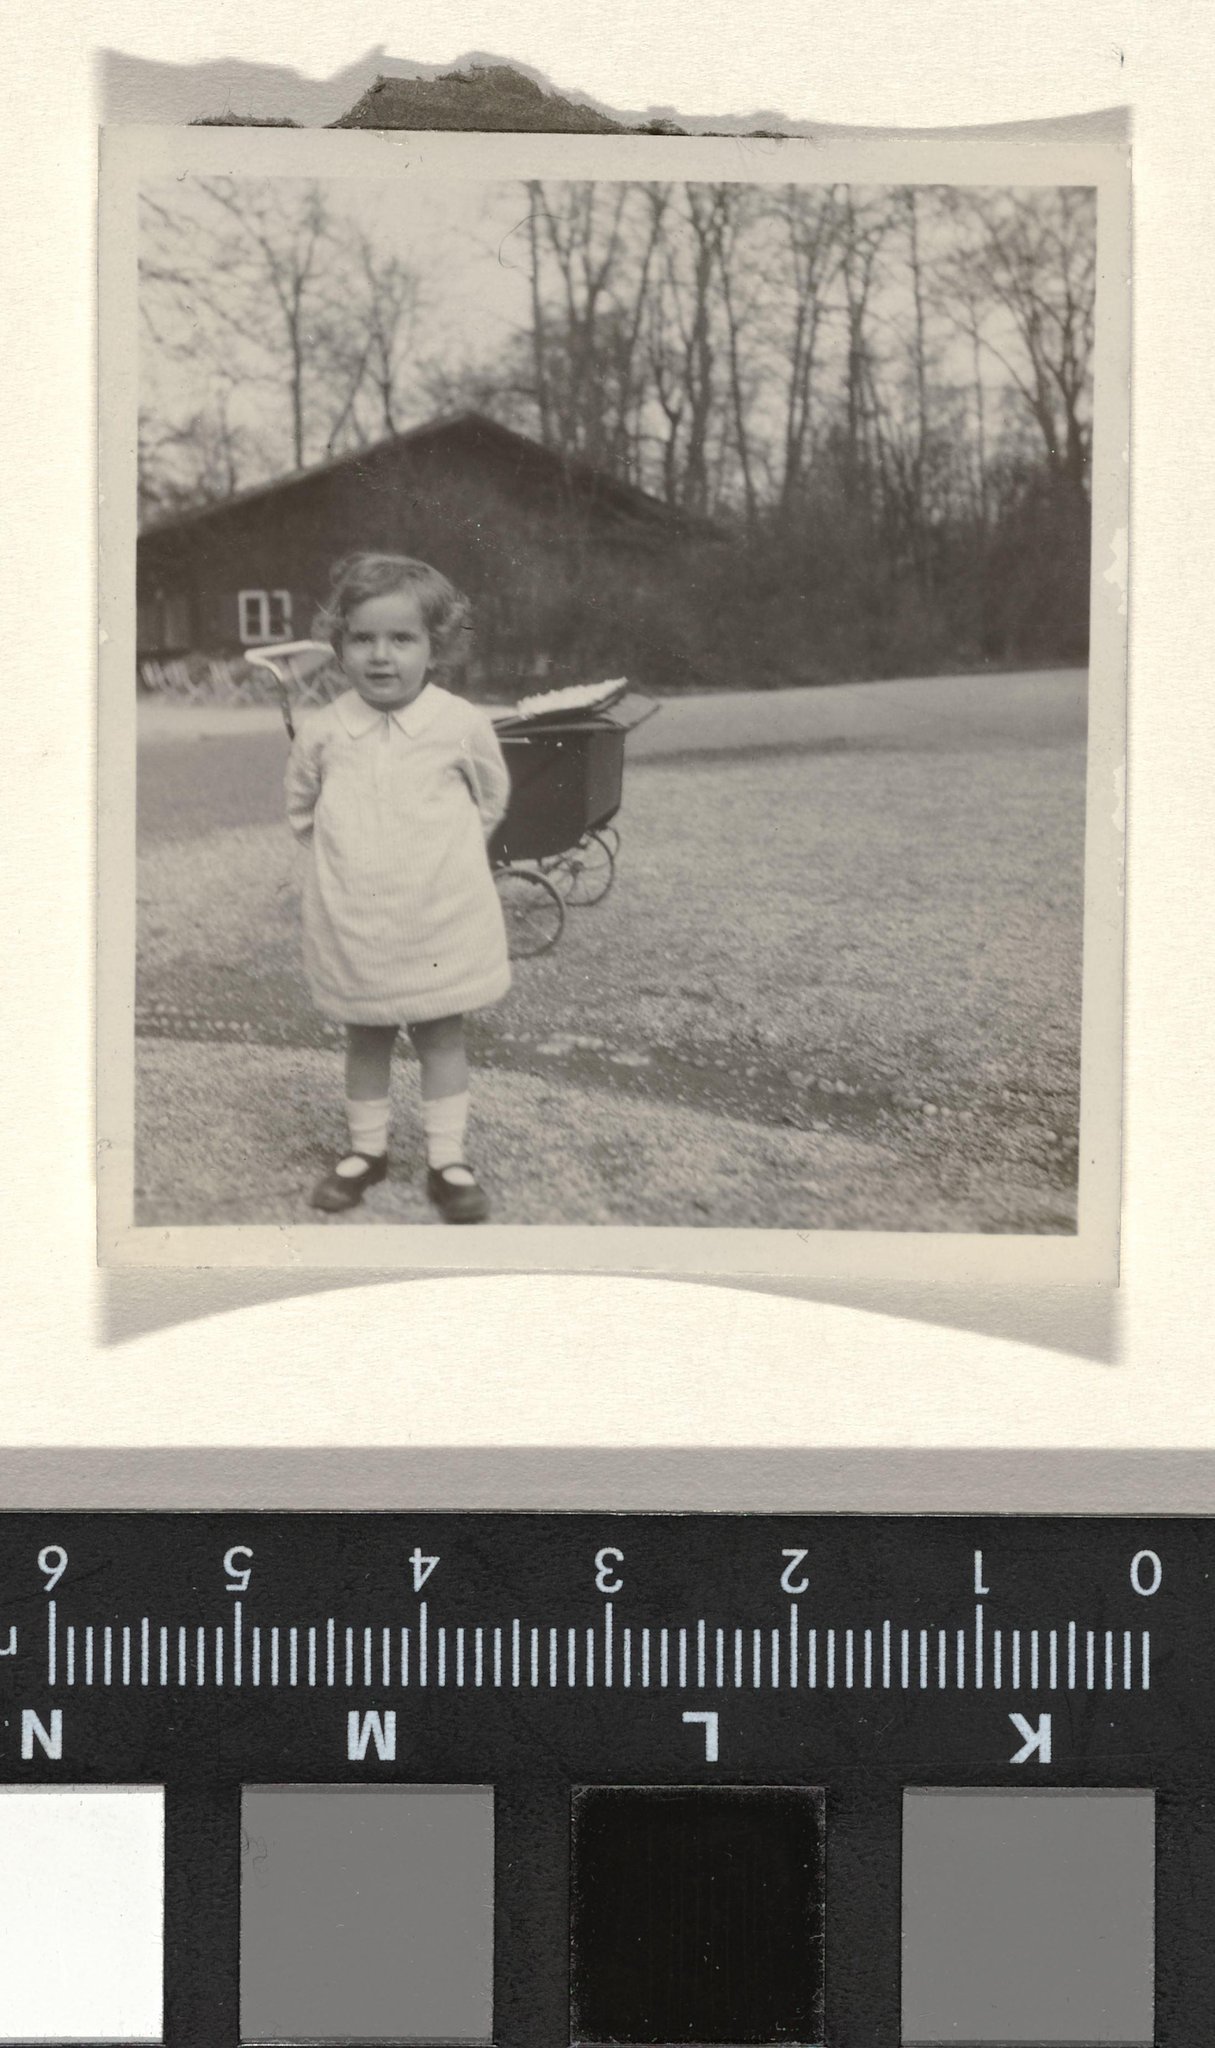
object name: photograph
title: Isabel Wachenheimer in de Engelse Tuinen in München, in september 1930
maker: Anonymous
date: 1909-1930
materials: photographic support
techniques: gelatin silver print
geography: munich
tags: leiden, isabel wachenheimer-elon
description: Dit object is onderdeel van de nalatenschap van Isabel Elon-Wachenheimer (1928-2010). Tot haar overlijden behoorde het samen met de andere objecten uit de nalatenschap tot haar privédomein van Isabel Wachenheimer. In die particuliere context zijn deze objecten tezamen en individueel aandenkens - aan de jeugd, ouders en familie van Isabel Wachenheimer vóór en tijdens de Shoah en aan haar leven na de Tweede Wereldoorlog. Isabel Wachenheimer, die van juni 1943 tot mei 1945 gevangen zat in Kamp Westerbork, Theresienstadt, Auschwitz, Lenzing a/d Oberdonau (een buitenkamp van Mauthausen), overleefde de Shoah. Haar ouders – Eugène Wachenheimer en Else Wachenheimer-Moos - werden op 14 oktober 1944 in Auschwitz-Birkenau vermoord.